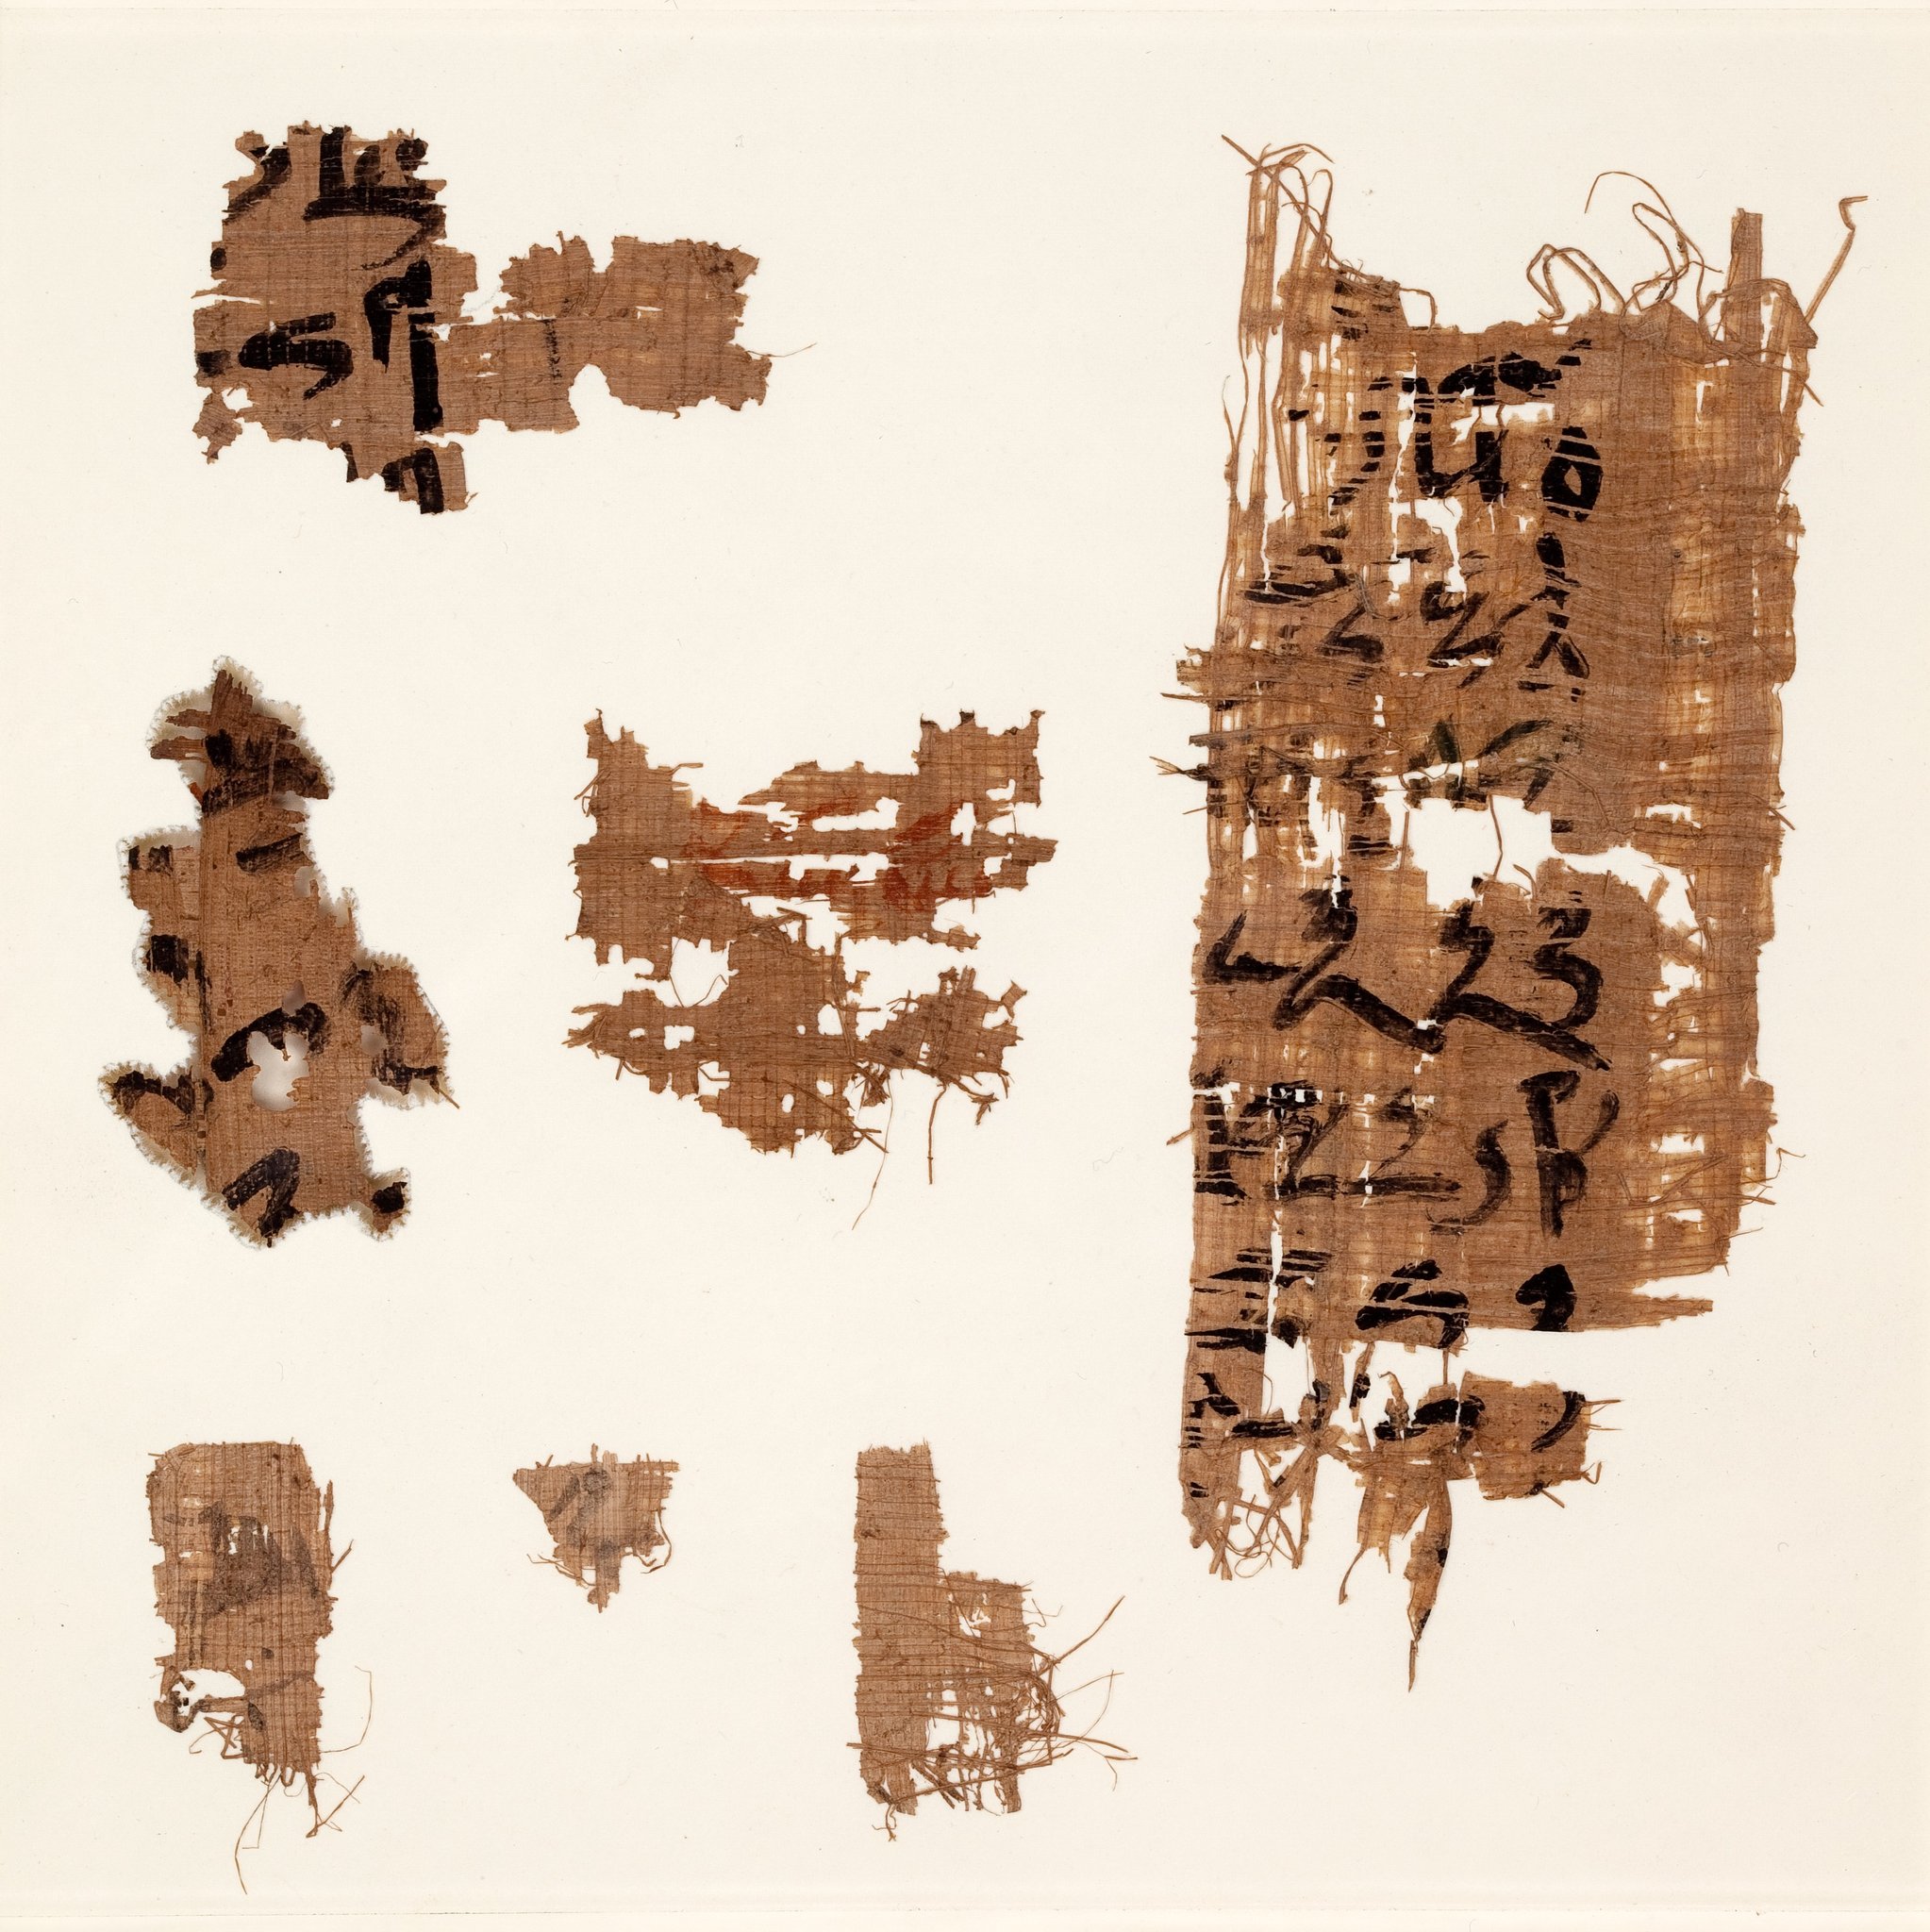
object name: papyrus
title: Seven papyrus fragments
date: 1981-1640 BCE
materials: ink, papyrus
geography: egypt